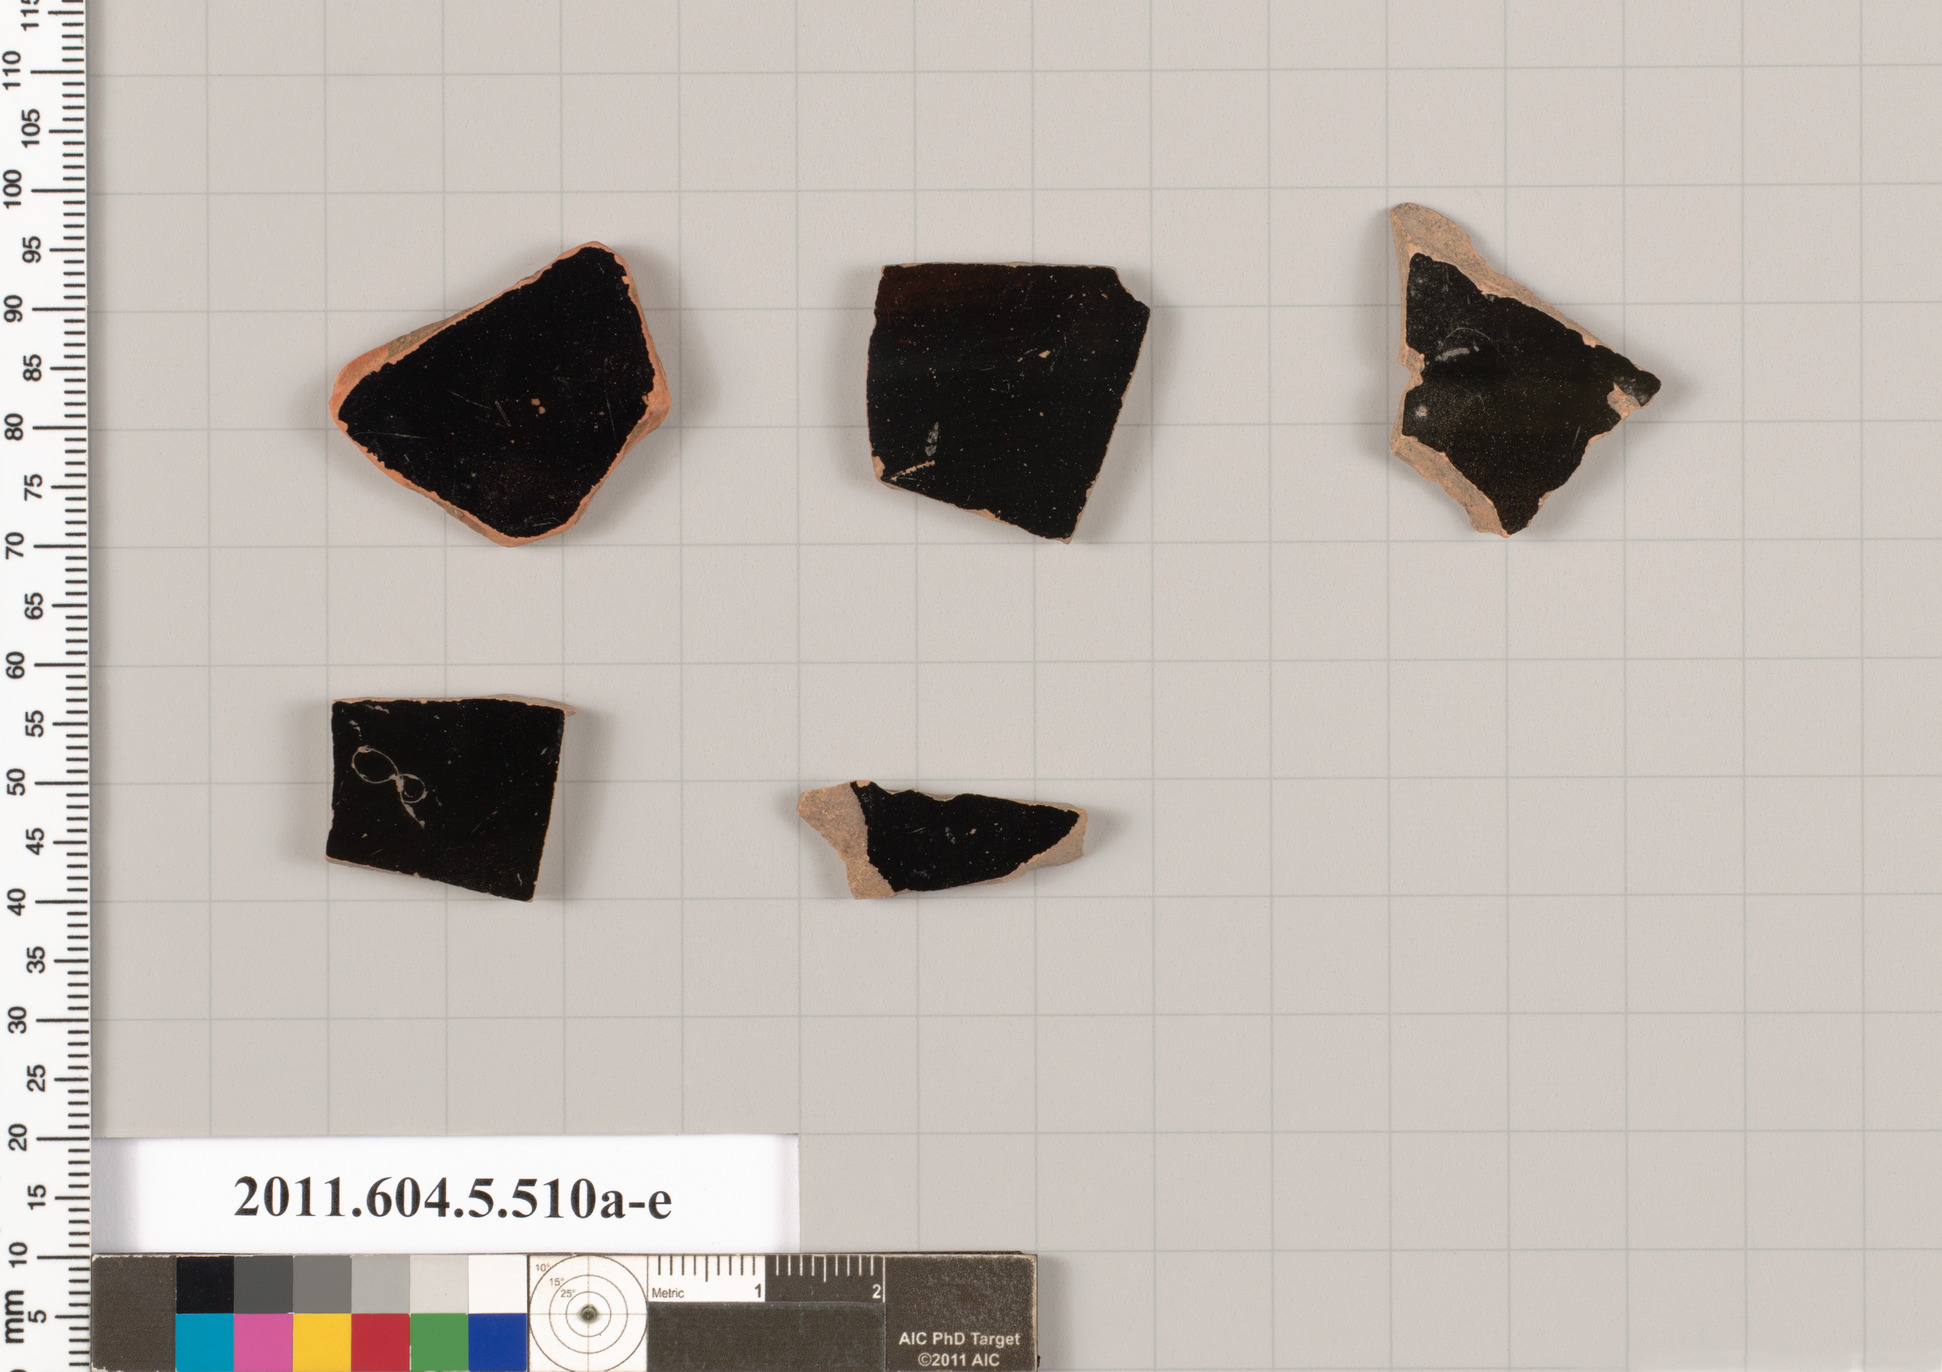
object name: kylix fragment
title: Terracotta fragments of kylikes (drinking cups)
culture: greek, attic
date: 600-401 BCE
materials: terracotta